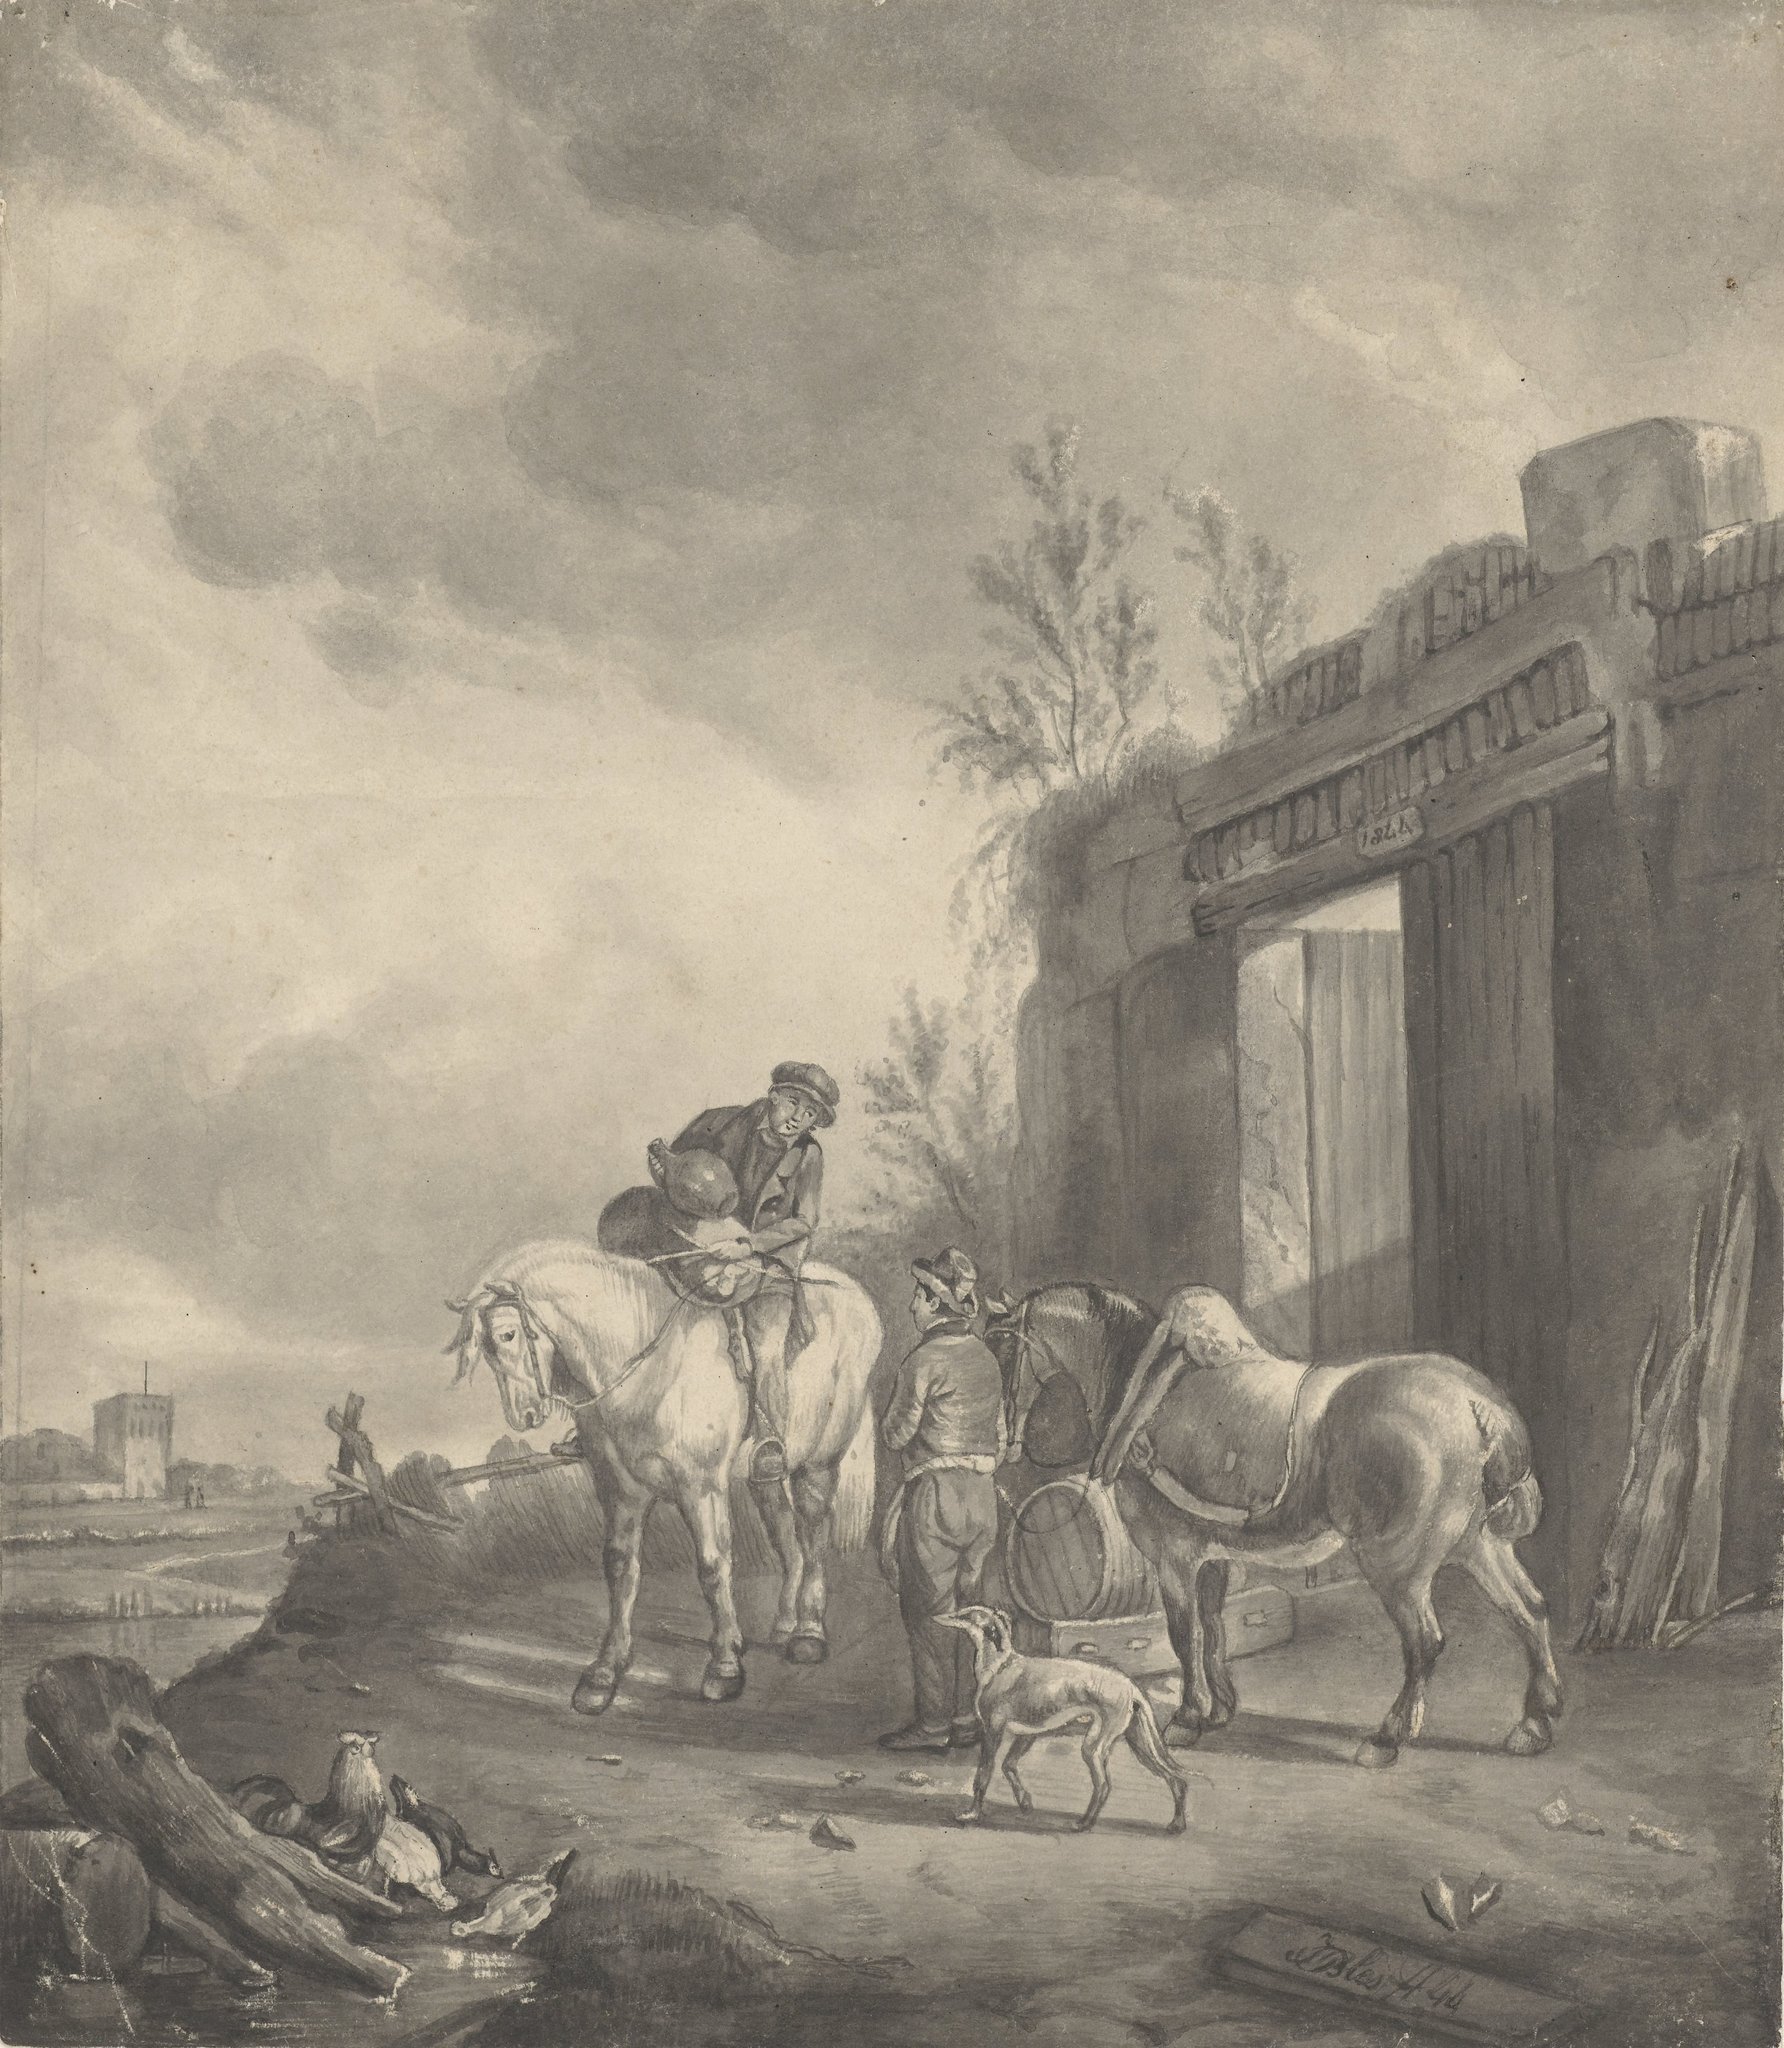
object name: drawing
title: Twee ruiters bij een vervallen gebouw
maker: joseph bles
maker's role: draughtsman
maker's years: 1825-1875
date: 1844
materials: ink, paper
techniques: brush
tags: riding a horse, ass, or mule; rider, horseman